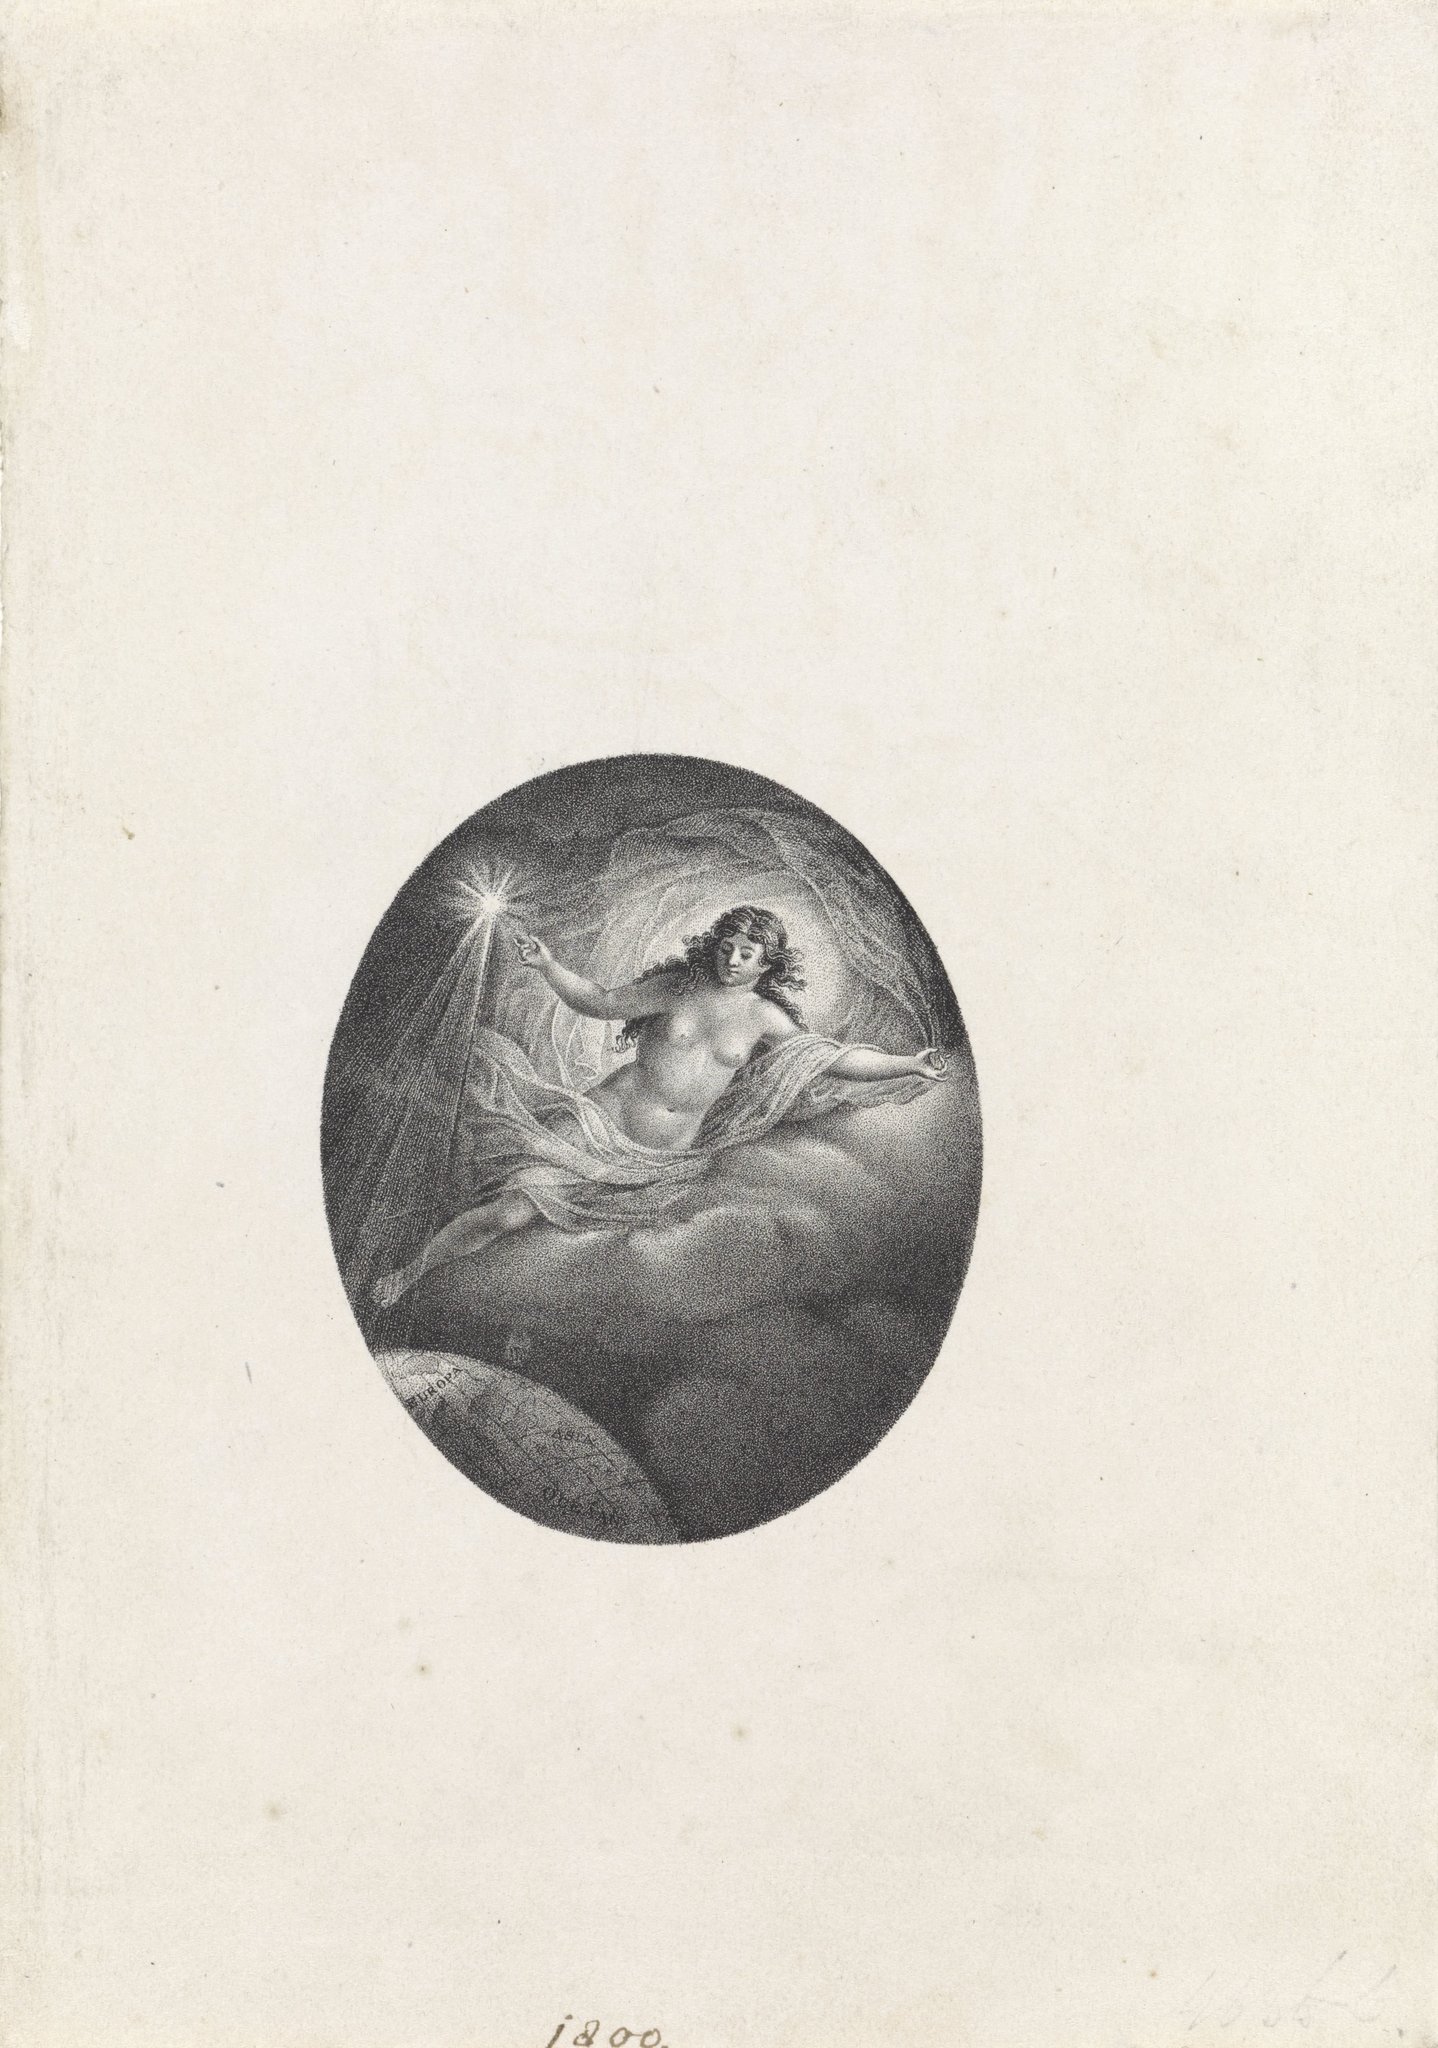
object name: print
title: Allegorie op de Verlichting, 1795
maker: Anonymous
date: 1795-1800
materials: paper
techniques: lithograph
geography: netherlands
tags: light shining out of the heavens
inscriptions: collector's mark: Lugt 2228, inscription: ‘1800’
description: Allegorie op de Verlichting, 1795. De vrouwelijke personificatie van de Verlichting zweeft boven de wereld en laat haar licht op Europa schijnen.